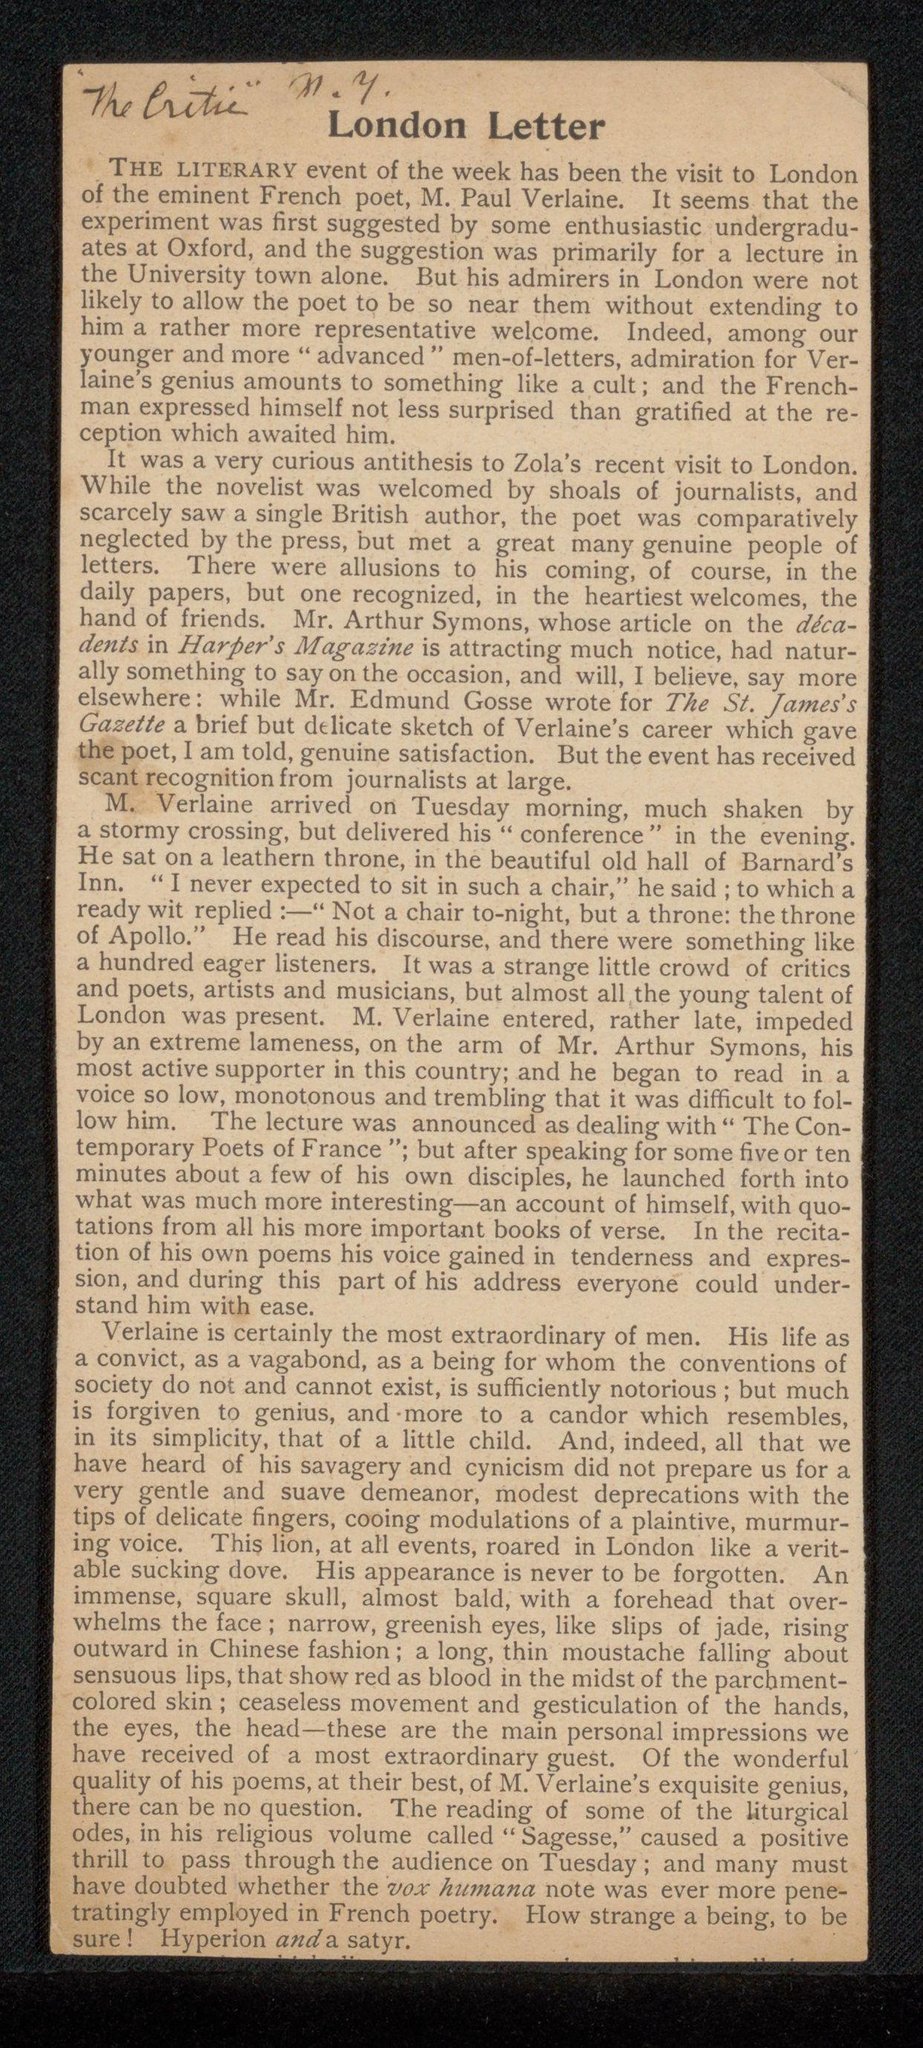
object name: newspaper clipping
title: Krantenknipsel uit archief Philip Zilcken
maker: Anonymous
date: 1894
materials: paper, ink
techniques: printing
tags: paris, paul verlaine, london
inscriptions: collector's mark: ‘RPK’